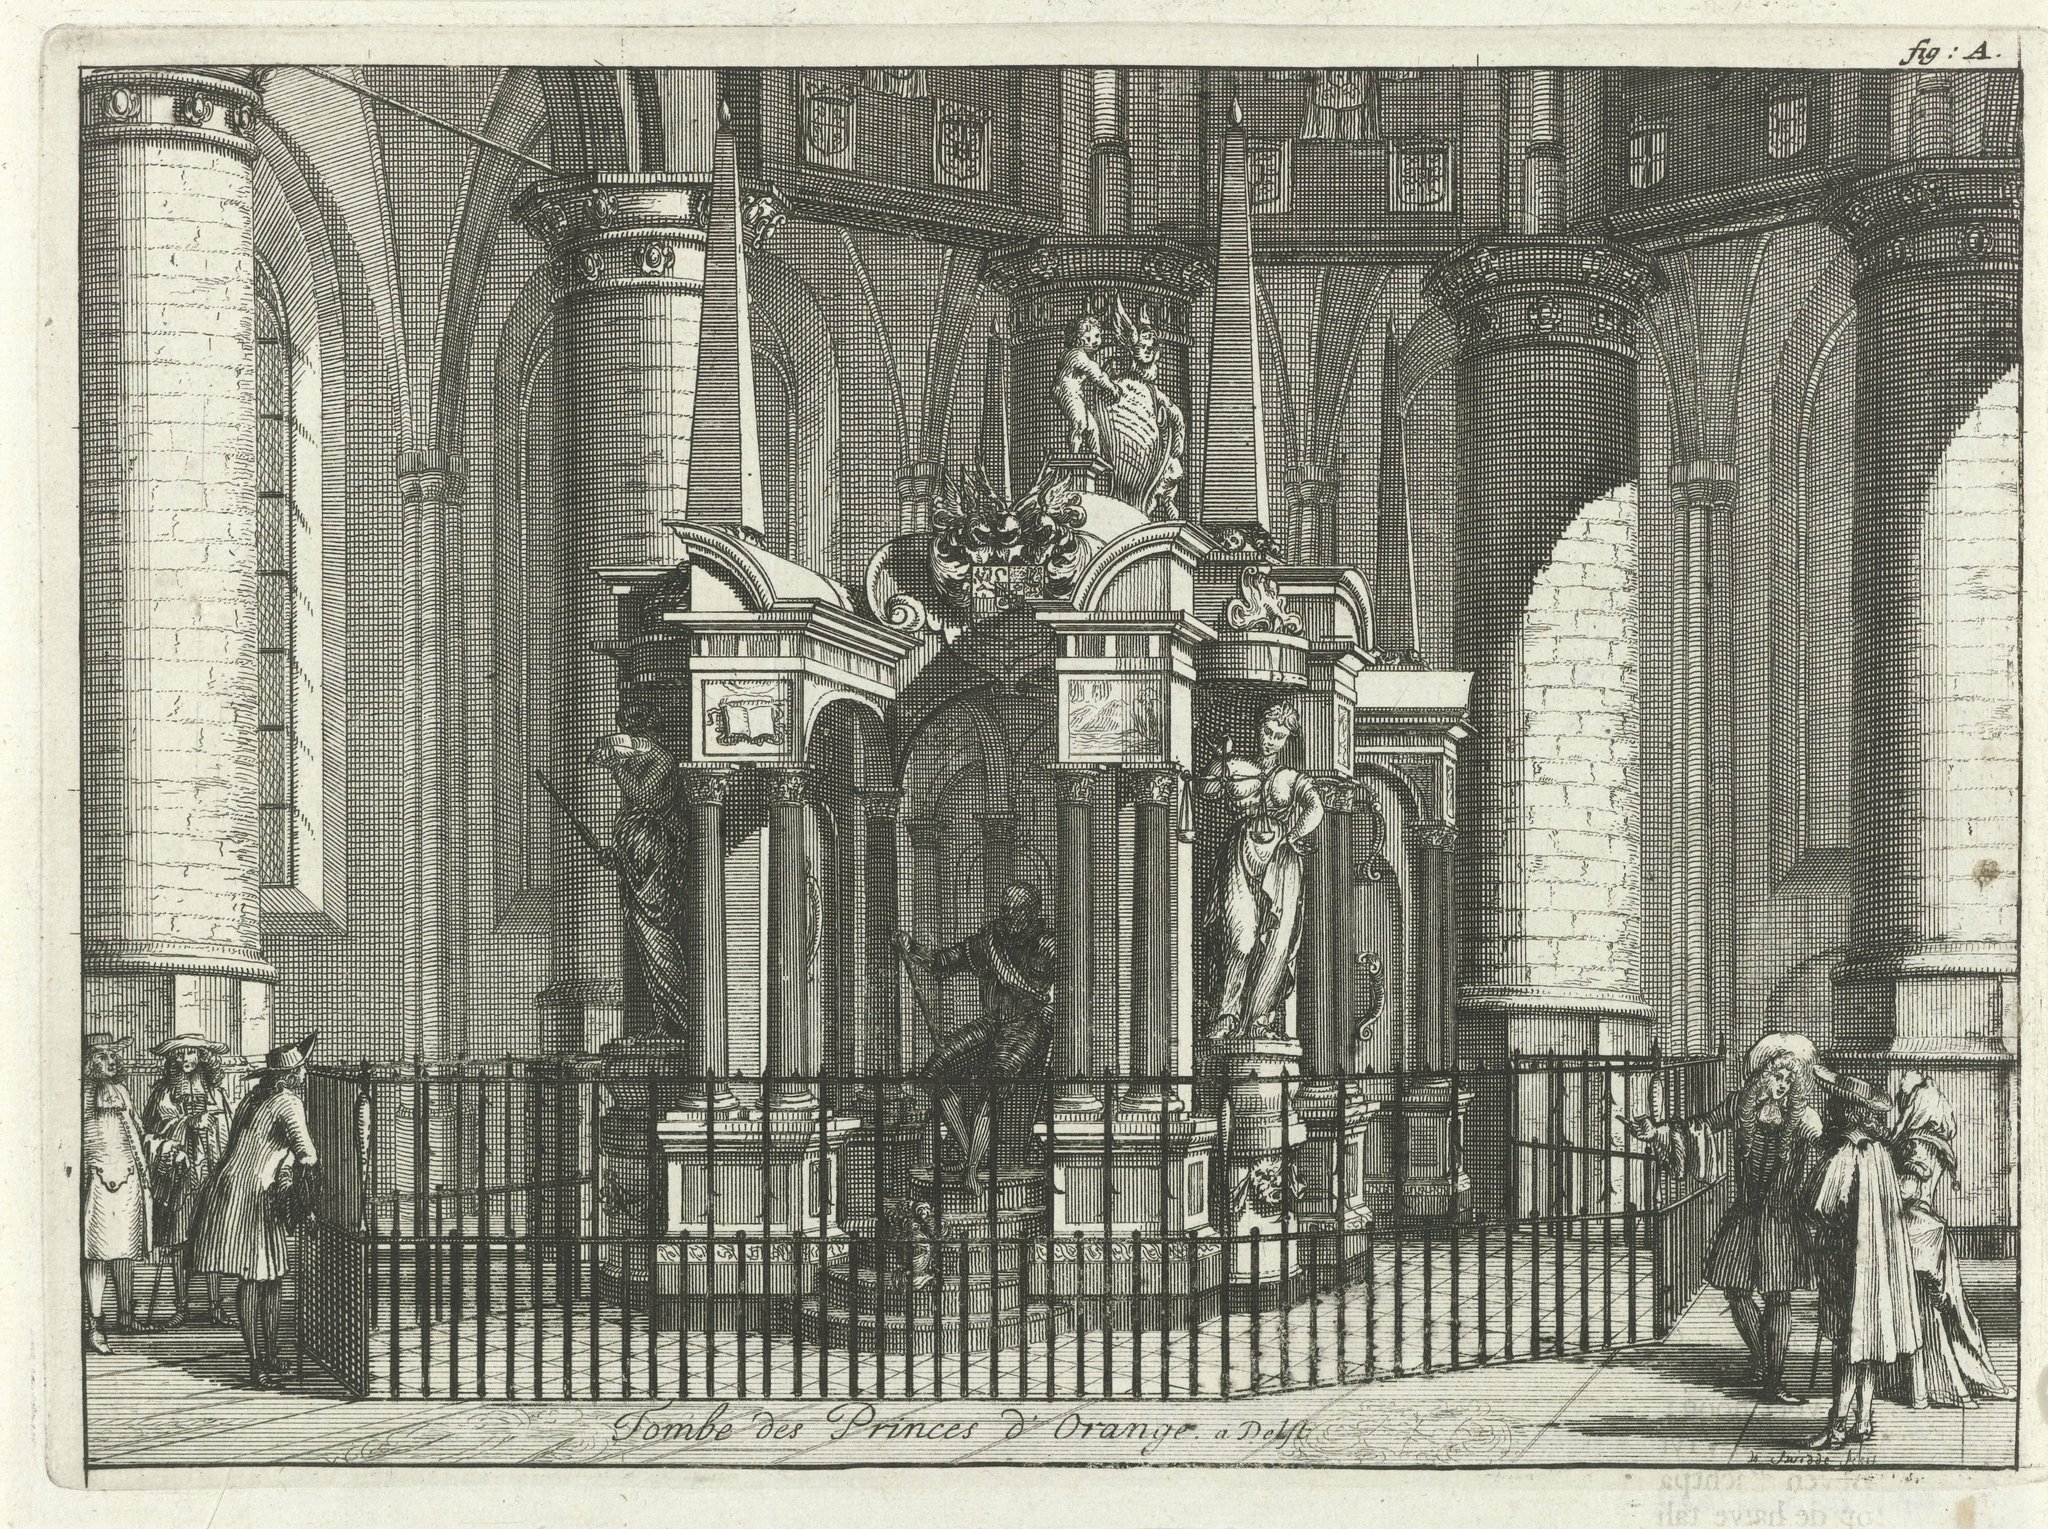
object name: print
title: Graftombe van Willem I, prins van Oranje, 1623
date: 1690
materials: paper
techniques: etching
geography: amsterdam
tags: delft, william i (prince of orange), historical persons, interior of church, grave-building, monumental tomb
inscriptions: collector's mark: Lugt 2228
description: De hier vermelde titel verwijst naar de hoogst verkregen titel van de geportretteerde, niet per se naar de titel die de geportretteerde op deze voorstelling draagt. Prent uit: Nederlands helden-tooneel, vertoonende zeer cierlĳk in koper gesneeden alle de grafsteden. Amsterdam: Pieter Mortier, 1690.